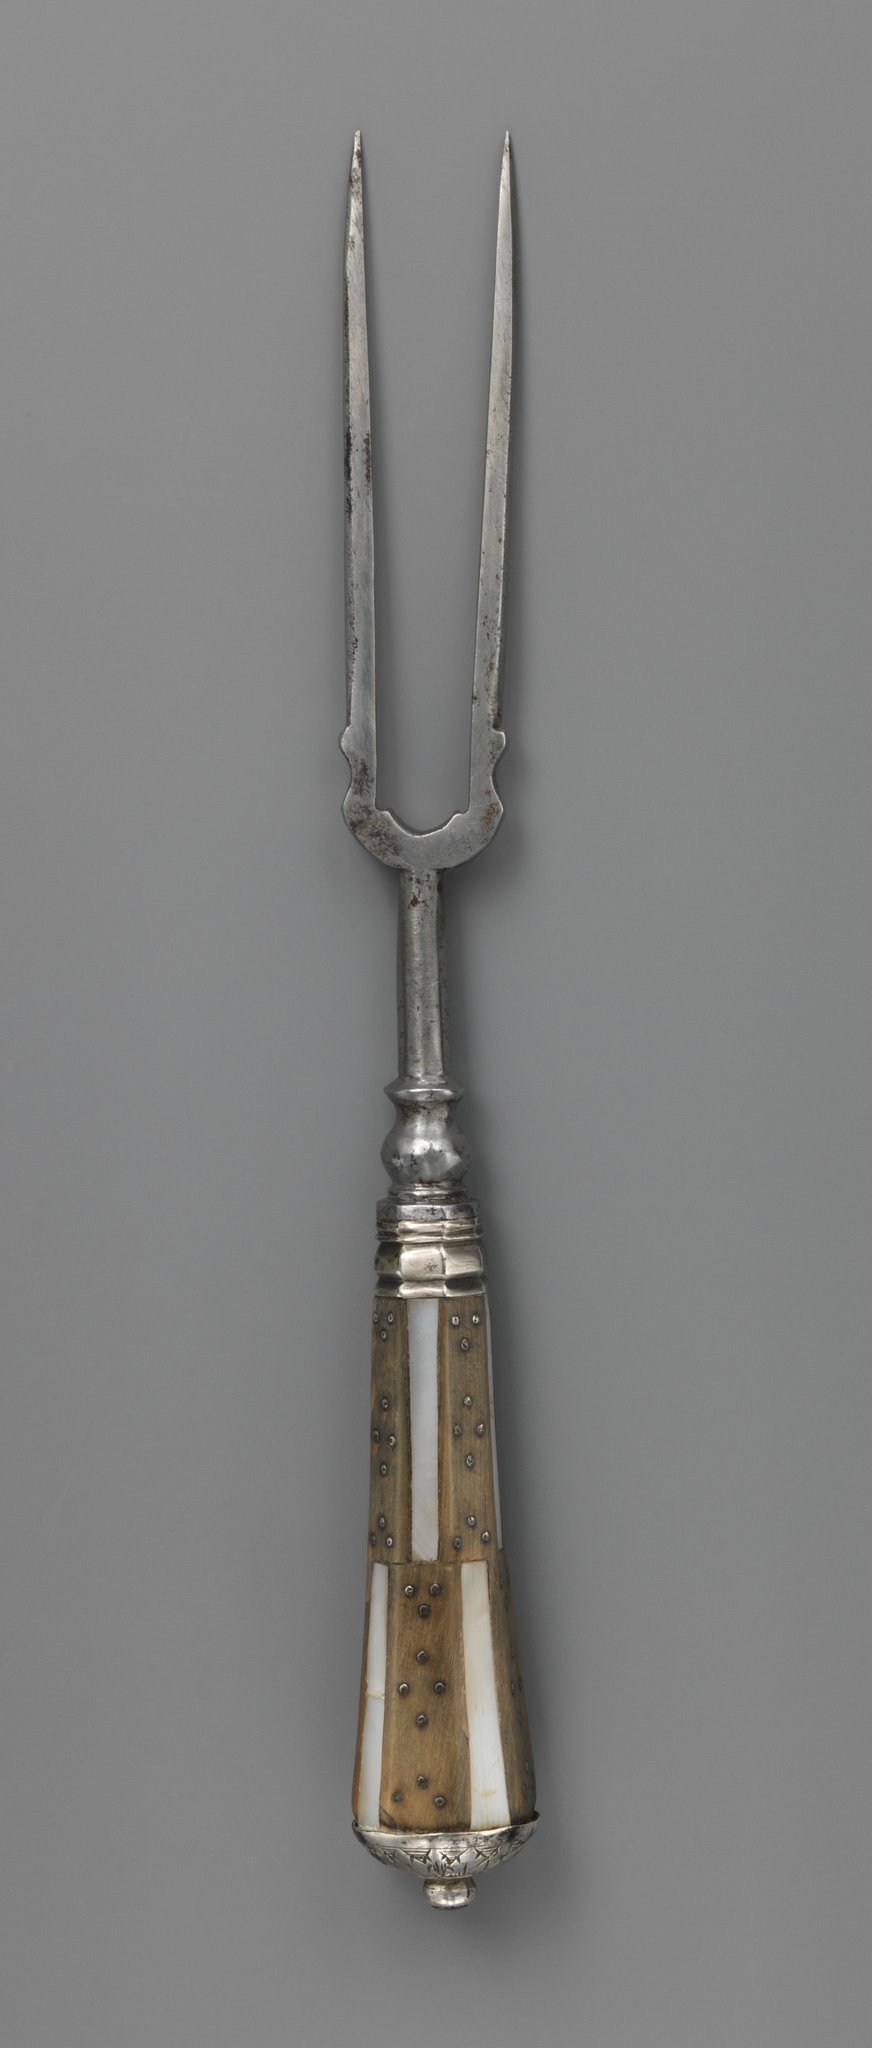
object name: table fork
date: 1601-1700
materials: mother of pearl, silver, steel, wood